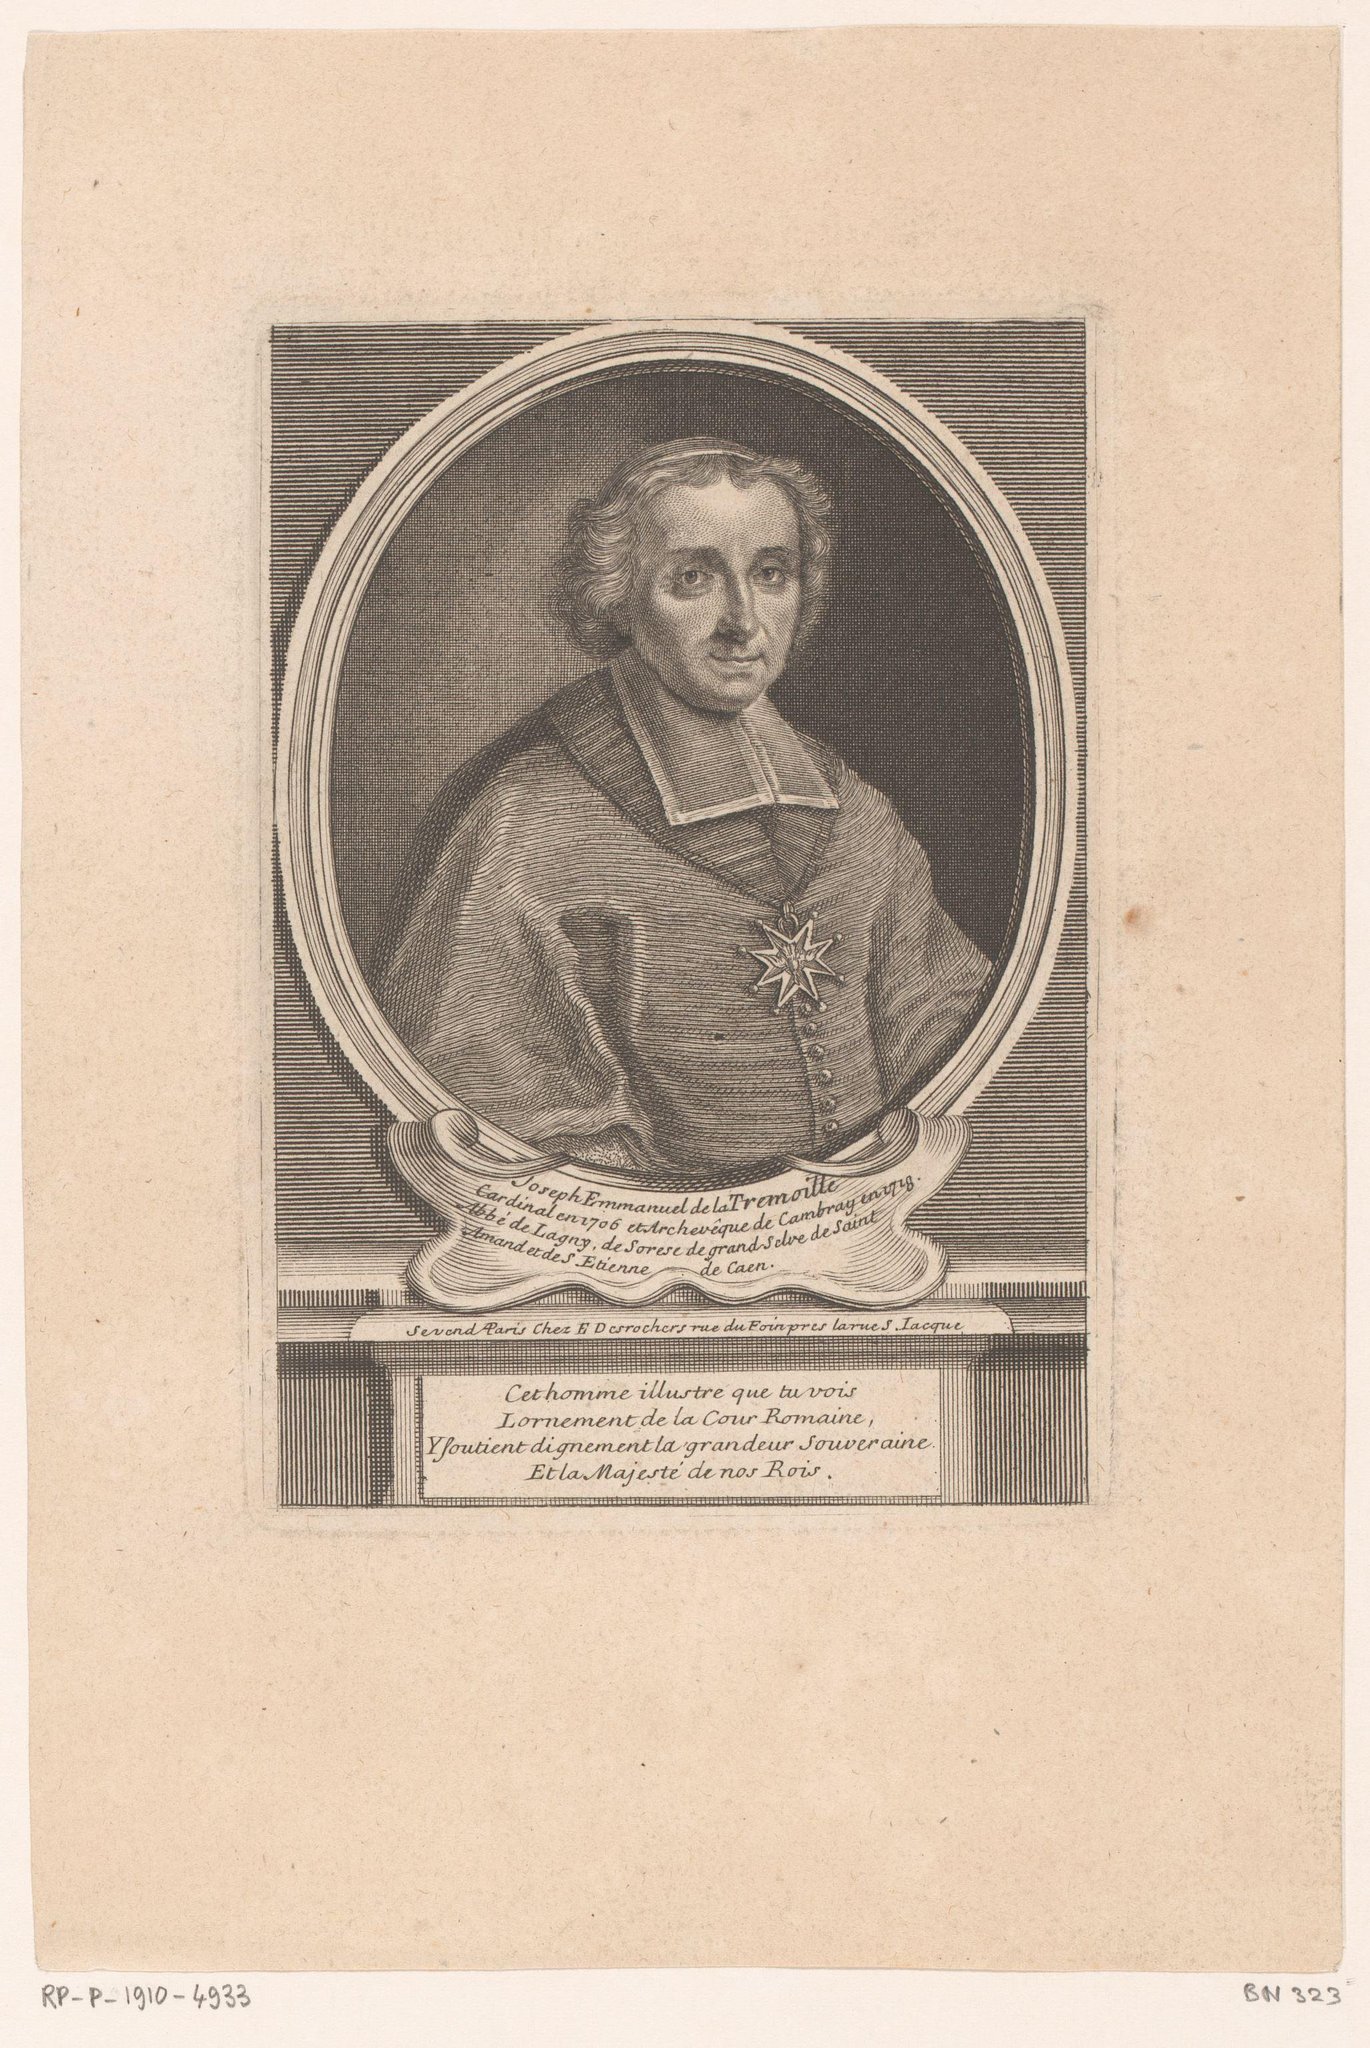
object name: print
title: Portret van Joseph-Emmanuel de La Trémoille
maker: étienne desrochers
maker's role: print maker, publisher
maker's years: 1668-1741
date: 1726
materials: paper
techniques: engraving, etching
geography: paris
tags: france, rome, cardinal, historical persons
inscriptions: collector's mark: Lugt 2228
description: Behoort waarschijnlijk tot een serie portretten, grotendeels door Etienne Desrochers, getiteld: 'Recueil de portraits de personnes qui se sont distinguées tant dans les Armes que dans Belles-Lettres et les Arts, comme aussi la famille royale de France et autres cours étrangères'. De serie werd initieel uitgegeven door Desrochers en aangekondigd in 'Mercure' in mei 1726, p. 985. Echter was Desrochers reeds enkele jaren eerder begonnen met het uitgeven van de serie. Na de dood van Desrochers werd de serie voortgezet door Gilles Edme Petit. Een latere staat werd uitgegeven door Jean François Daumont in Parijs.